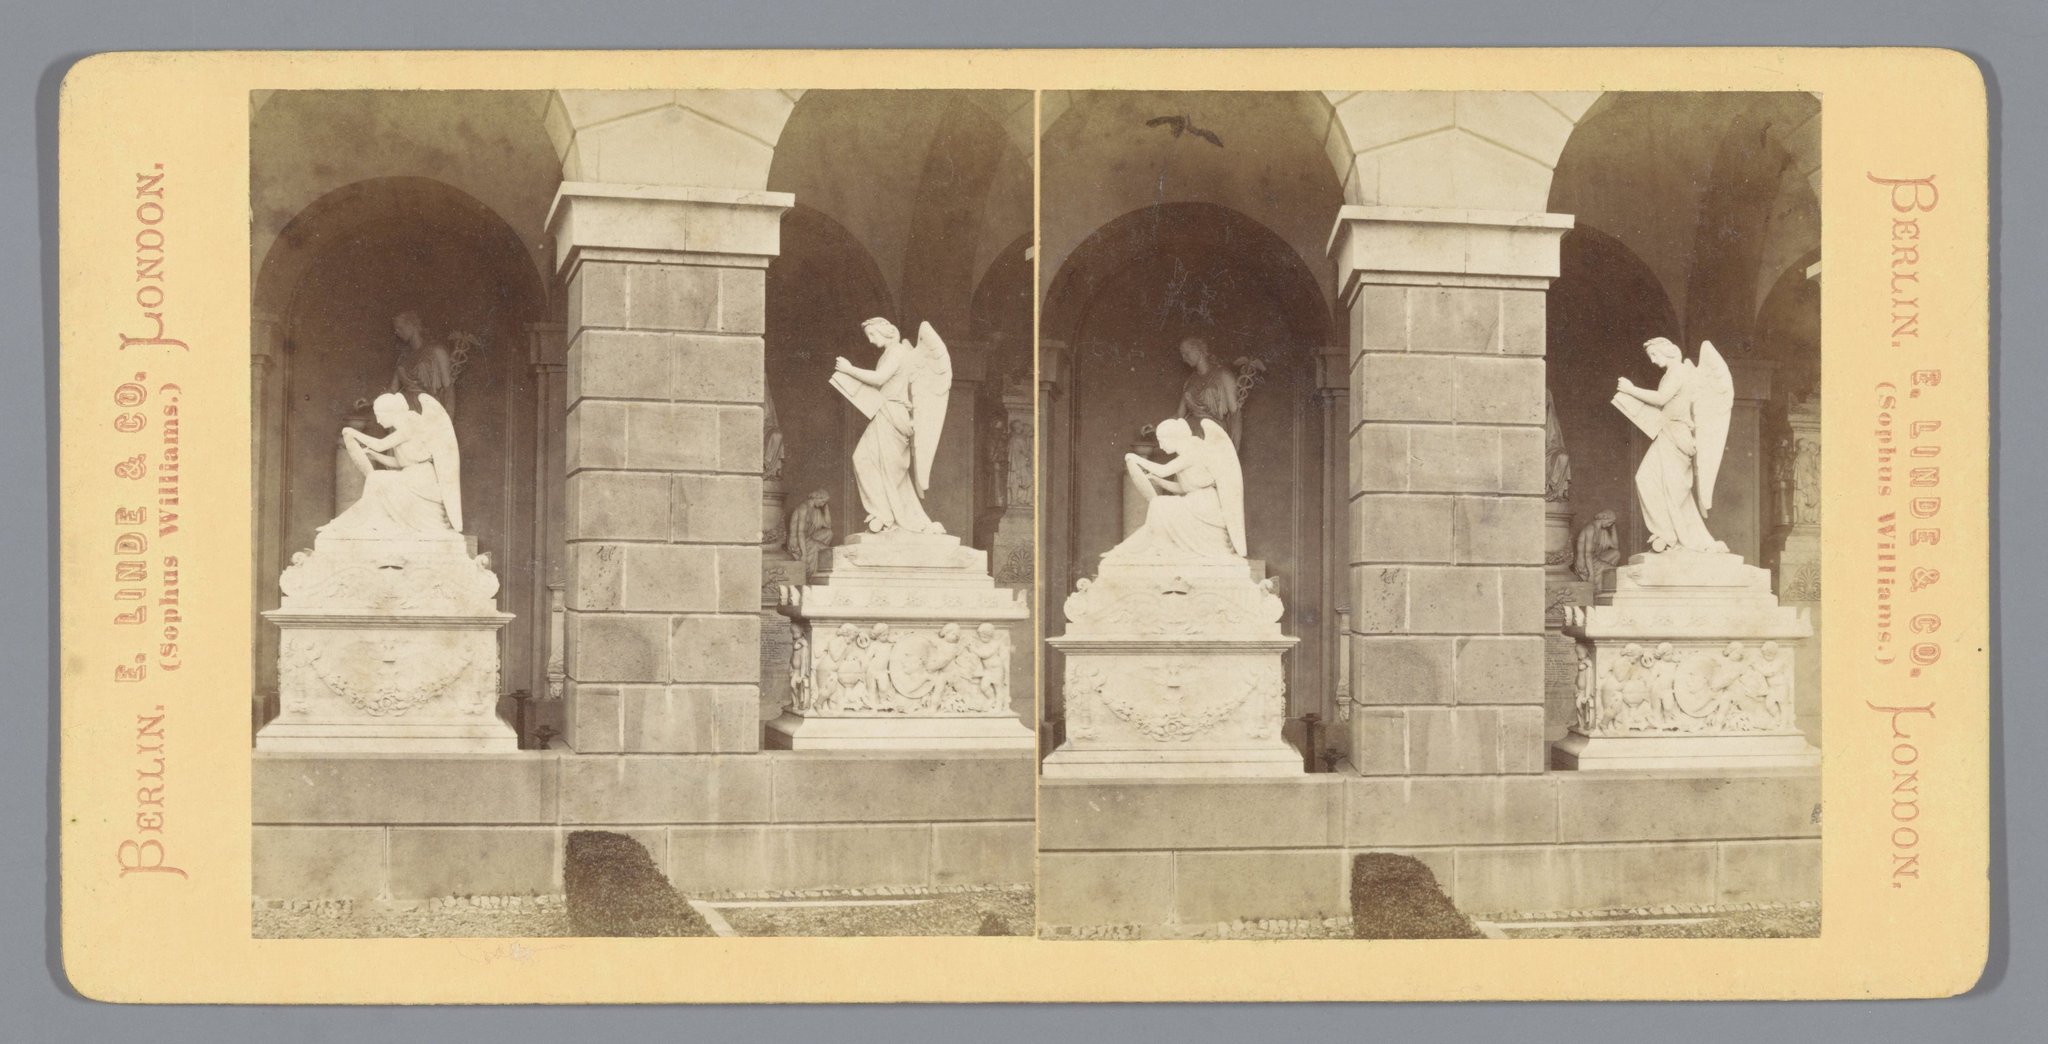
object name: stereograph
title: Graftombes in het Camposanto te Genua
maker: alfredo noack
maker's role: fotograaf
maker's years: 1833-1895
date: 1866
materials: cardboard, photographic support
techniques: albumen print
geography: genoa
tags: grave, tomb, sculpture, churchyard, cemetery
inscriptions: inscription: ‘Genua Campo Santo’, name: ‘E. LINDE & CO. (Sophus Williams.) BERLIN. LONDON.’, number: ‘No 152.’